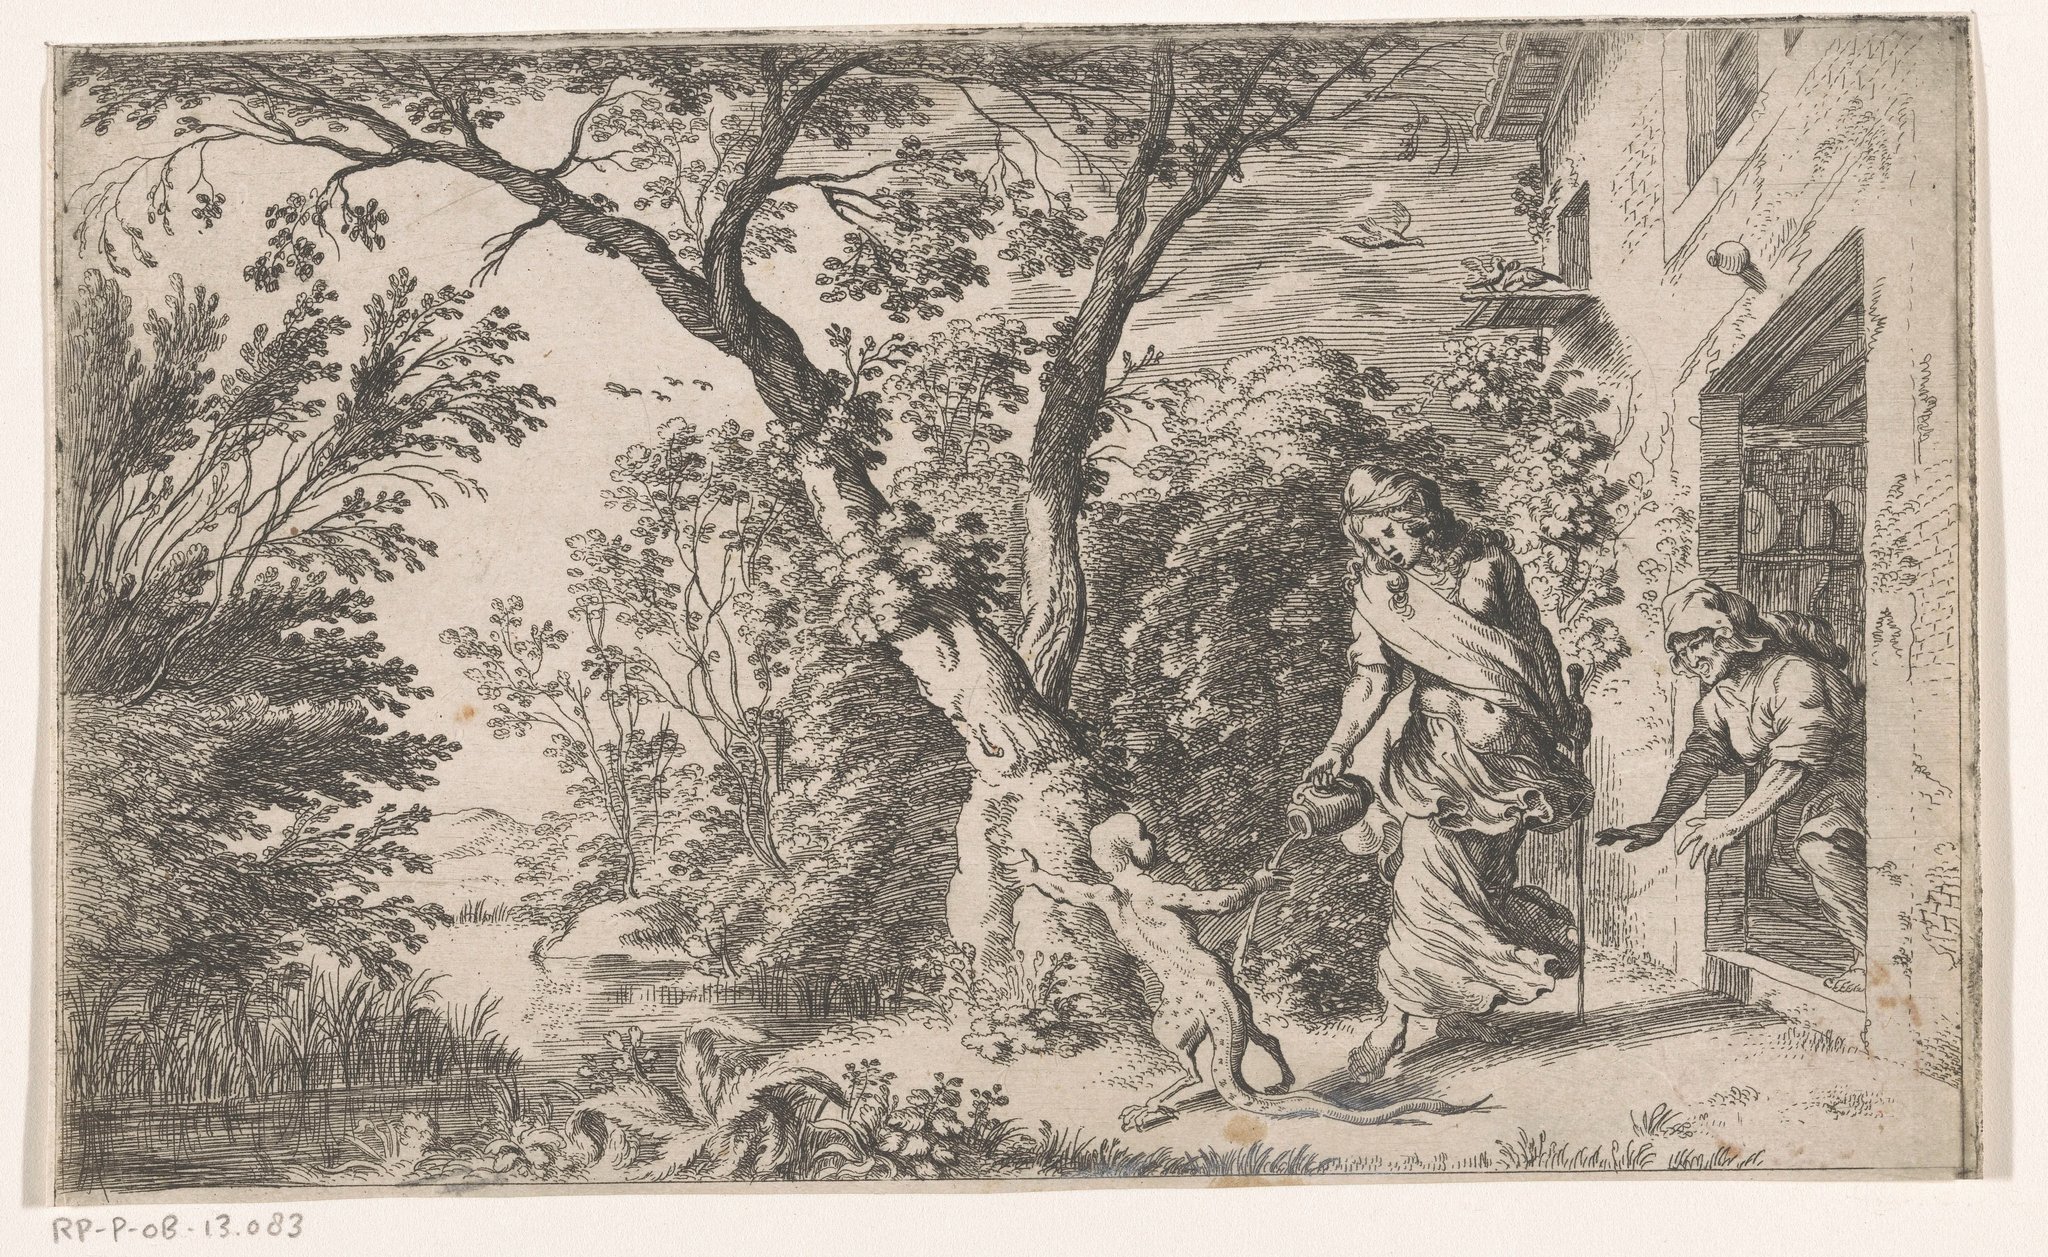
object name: print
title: Ceres verandert Ascalabus in een hagedis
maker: Anonymous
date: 1639-1700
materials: paper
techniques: etching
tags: ascalabus (stellio, abas) changed into a lizard: ceres changes the boy into a lizard as punishment for mocking her, when quenching her thirst too avidly (ovid, metamorphoses v 456)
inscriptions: collector's mark: Lugt 240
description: Anonieme kopie naar een prent uit de serie 'Metamorfosen van Ovidius', bestaand uit 150 prenten en een titelprent, uitgegeven tussen 1639-1641.